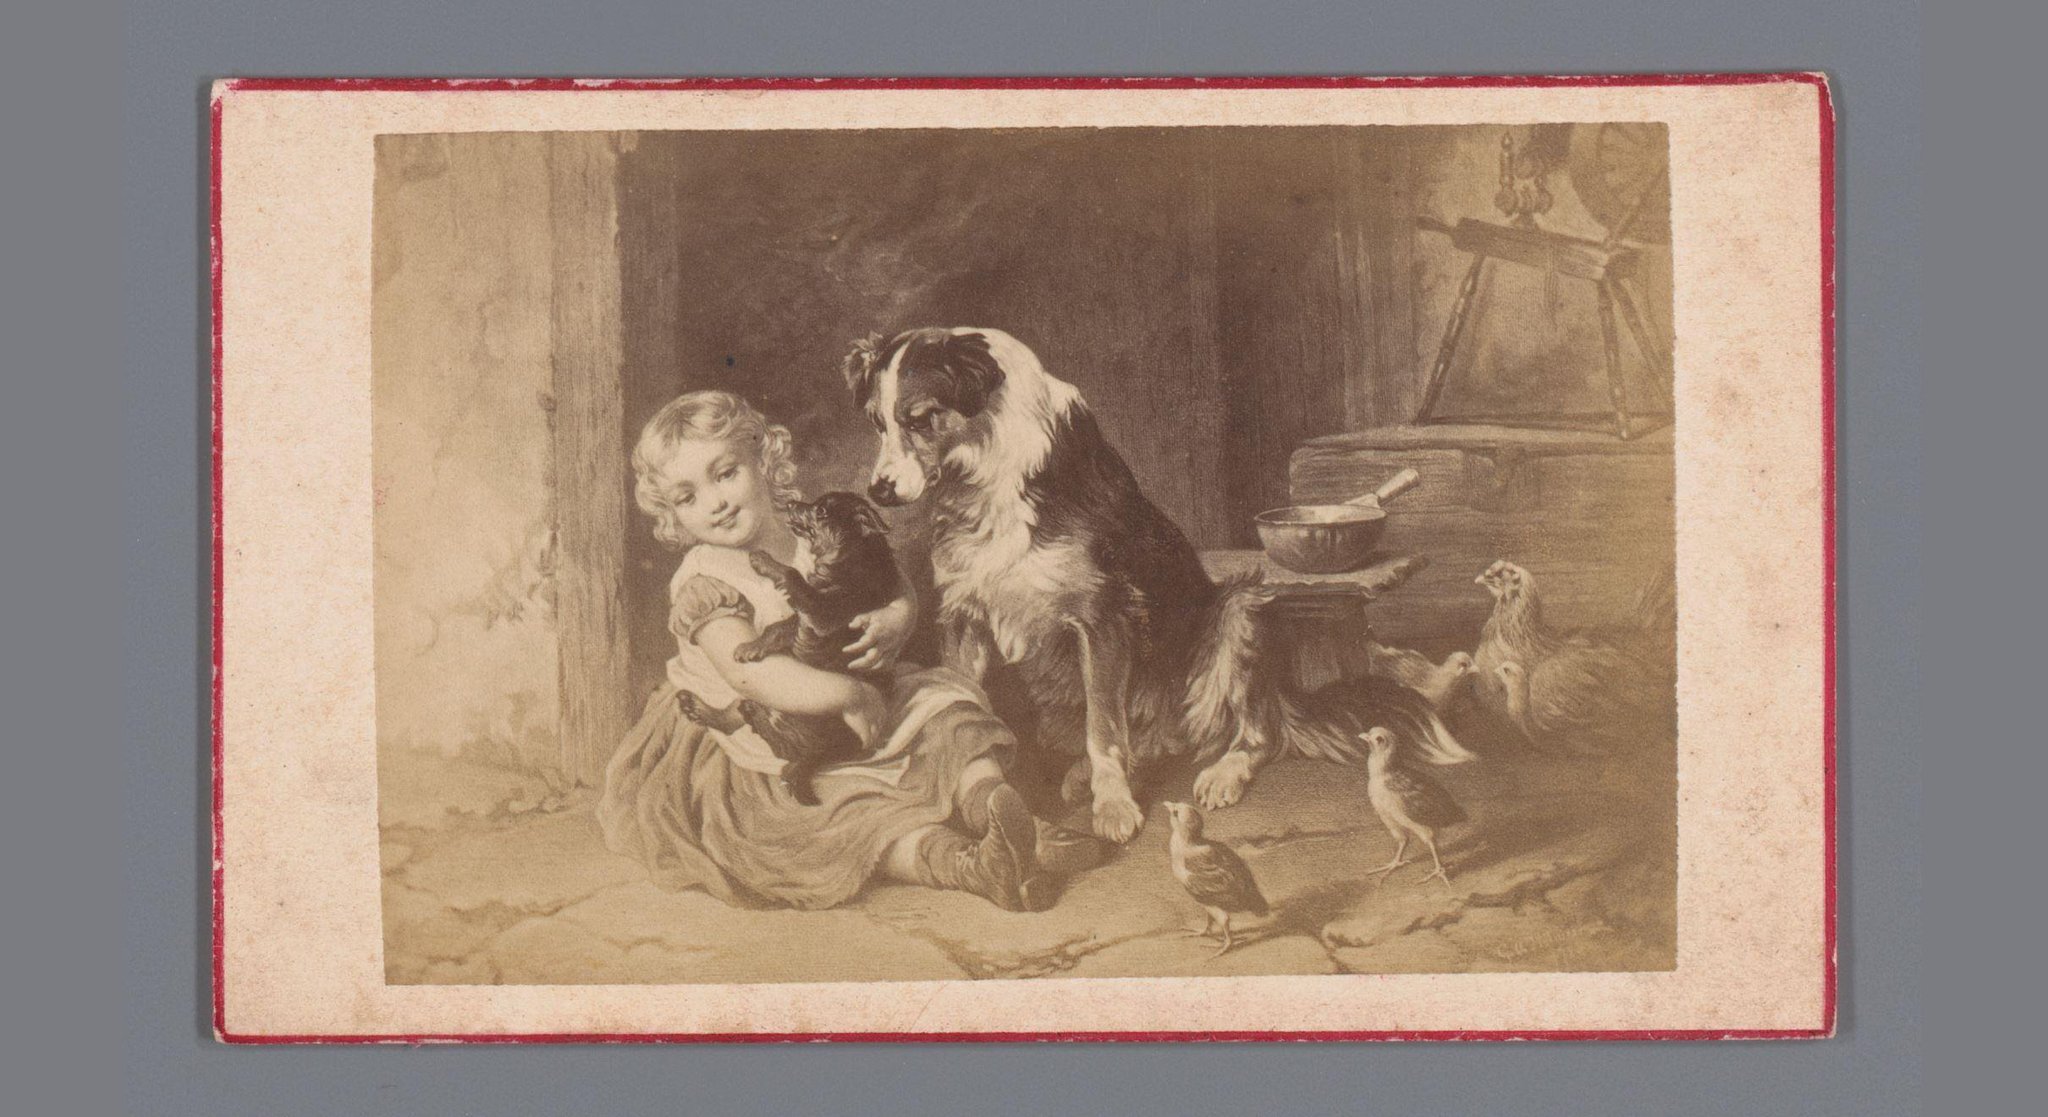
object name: reproduction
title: G.A. Holmes. Affection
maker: Anonymous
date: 1875-1914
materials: cardboard, paper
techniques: albumen print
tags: girl (child between toddler and youth), child playing with animals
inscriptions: number: ‘354’